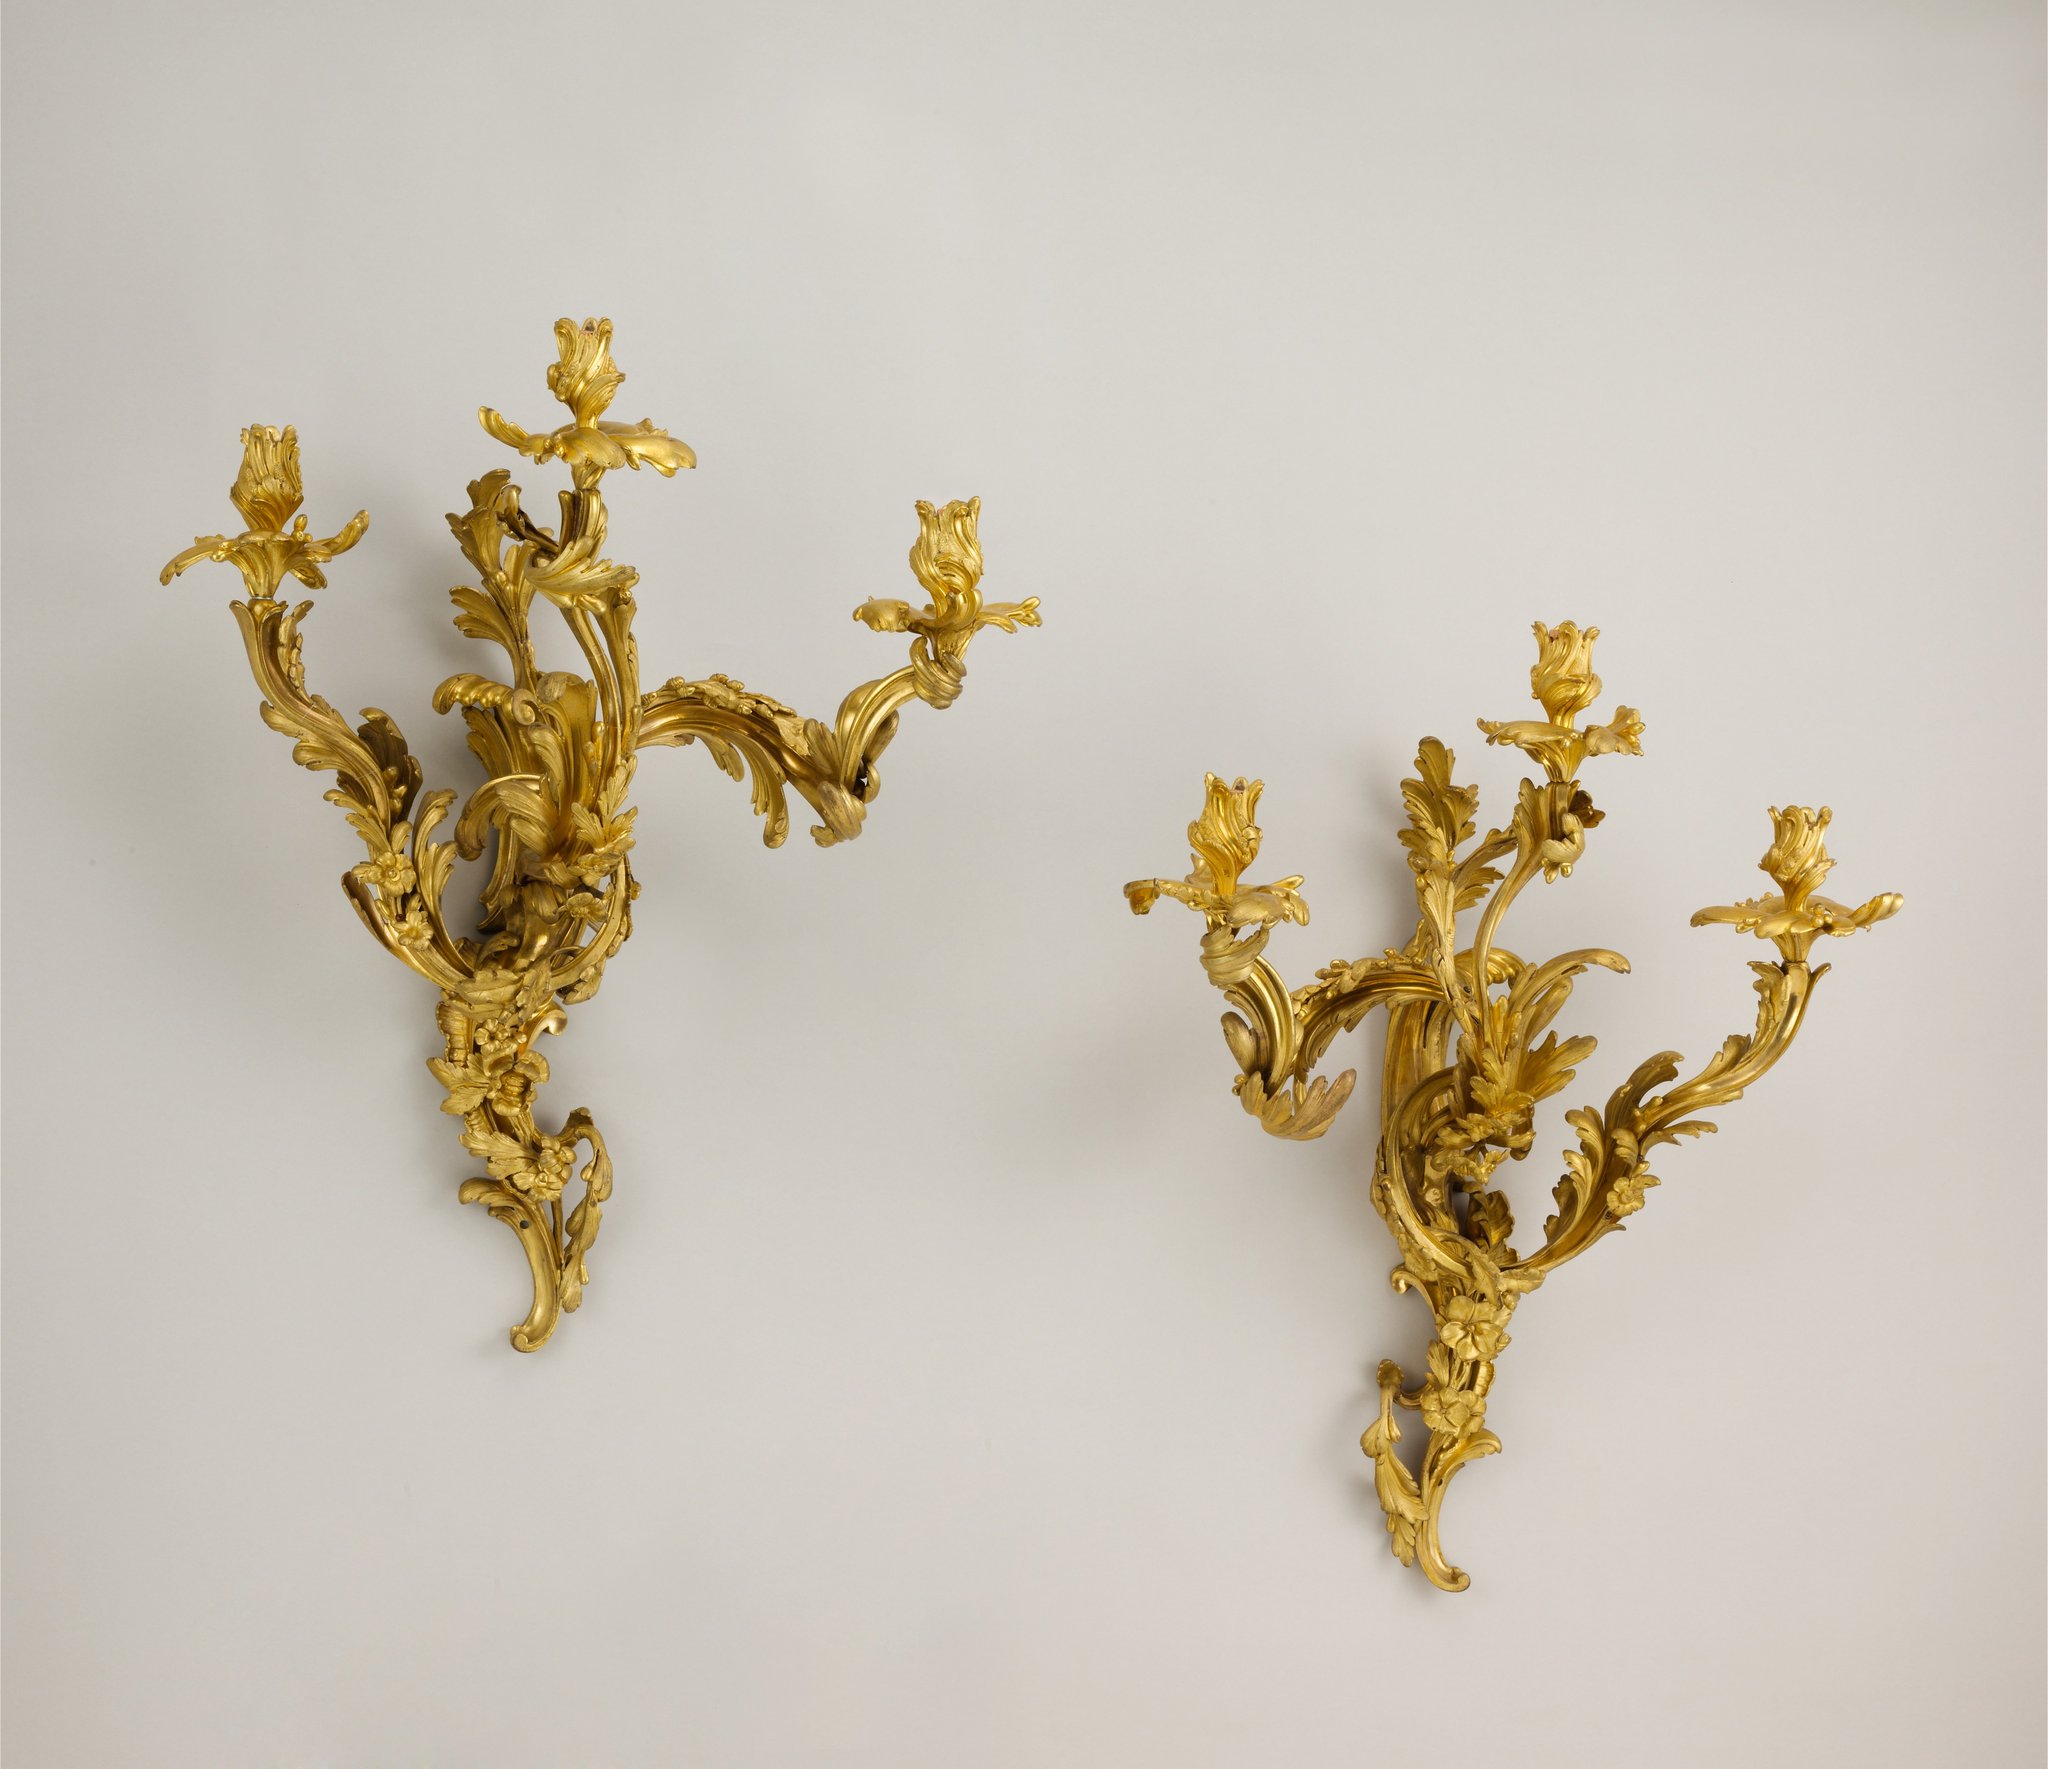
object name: sconce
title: Set of four three-light sconces (bras de lumière)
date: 1750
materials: gilt bronze